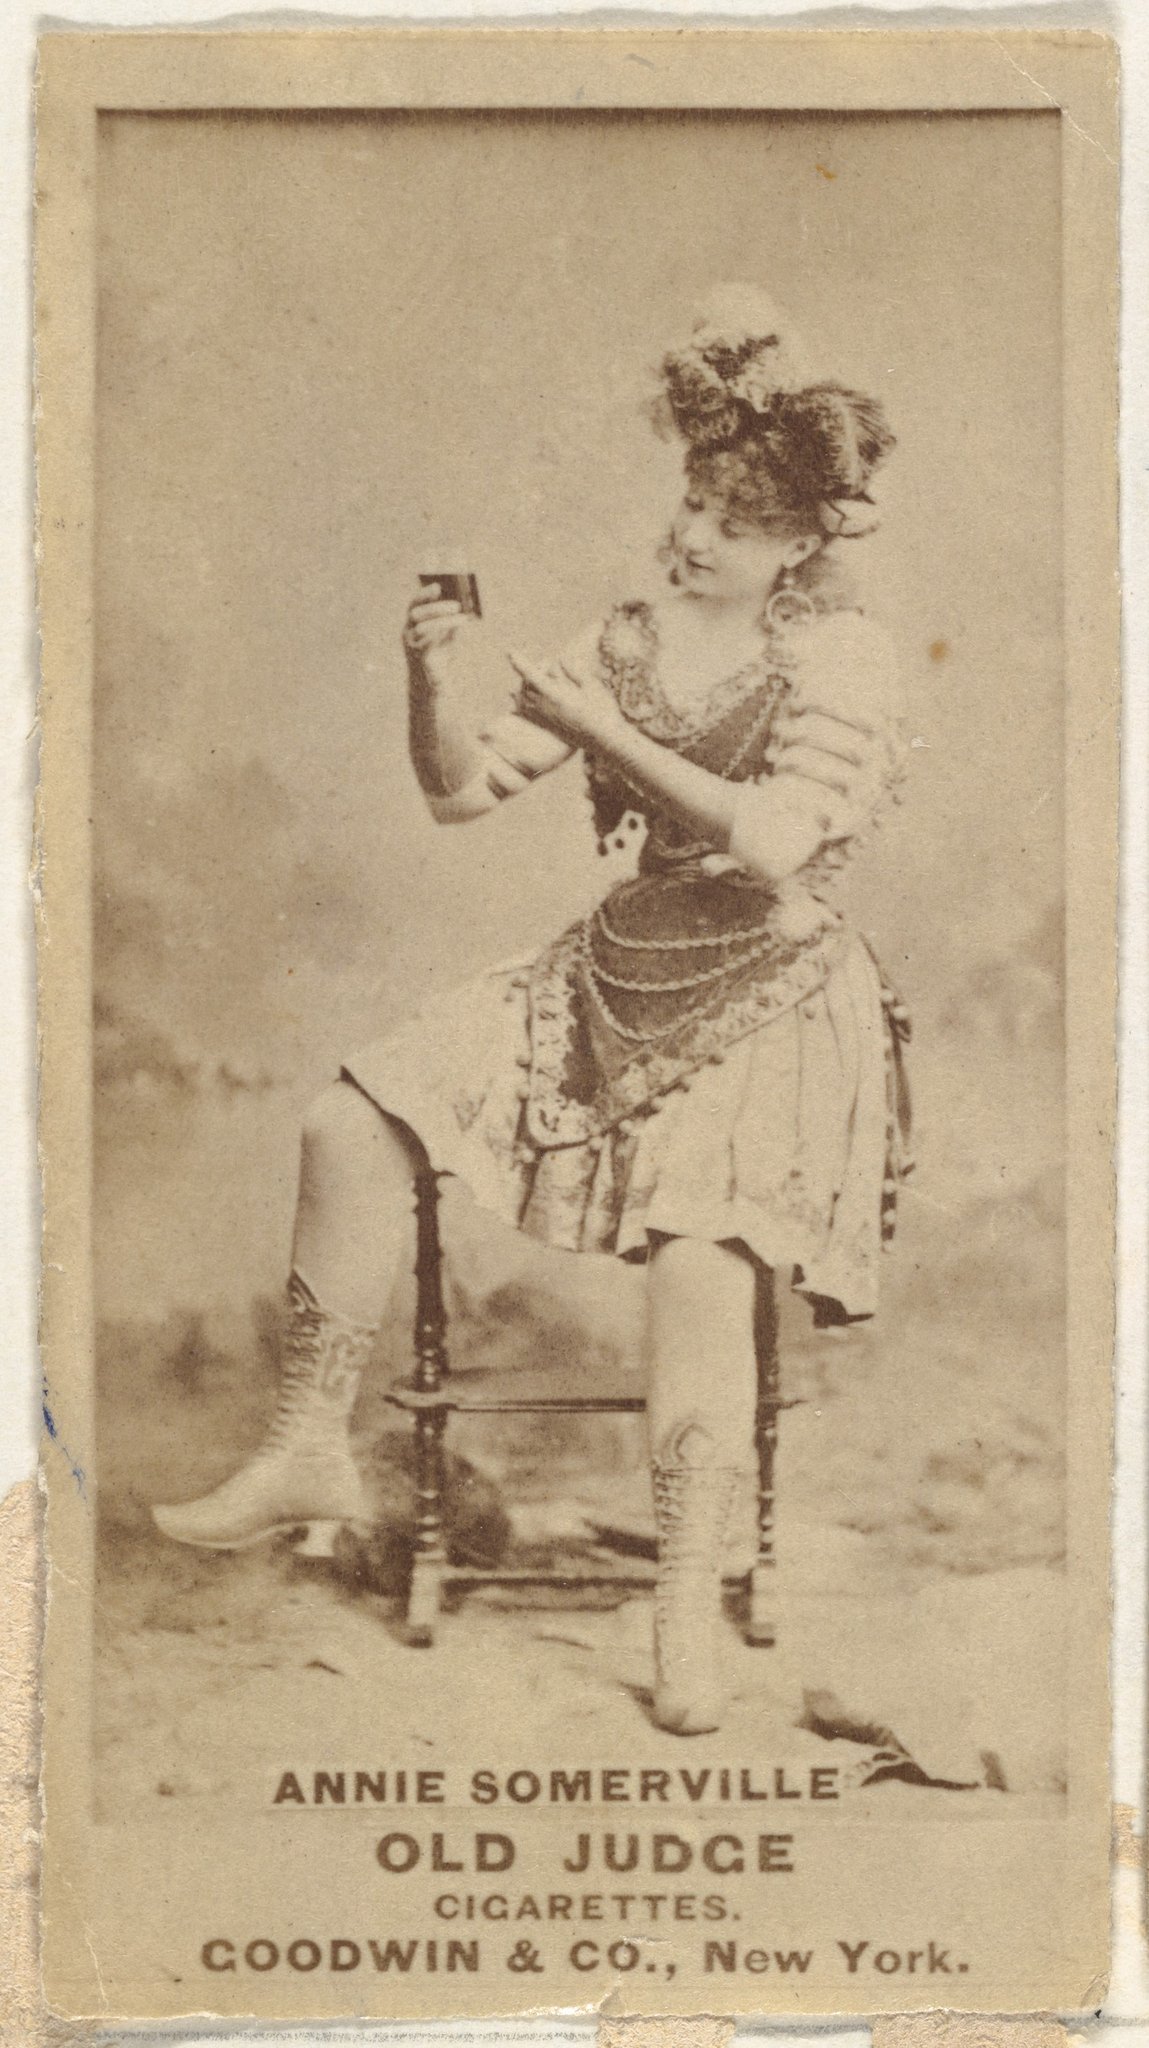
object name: photograph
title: Annie Somerville, from the Actors and Actresses series (N171) for Old Judge Cigarettes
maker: goodwin & company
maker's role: publisher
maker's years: 1850-1950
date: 1886-1890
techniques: albumen silver print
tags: portraits,women,actresses